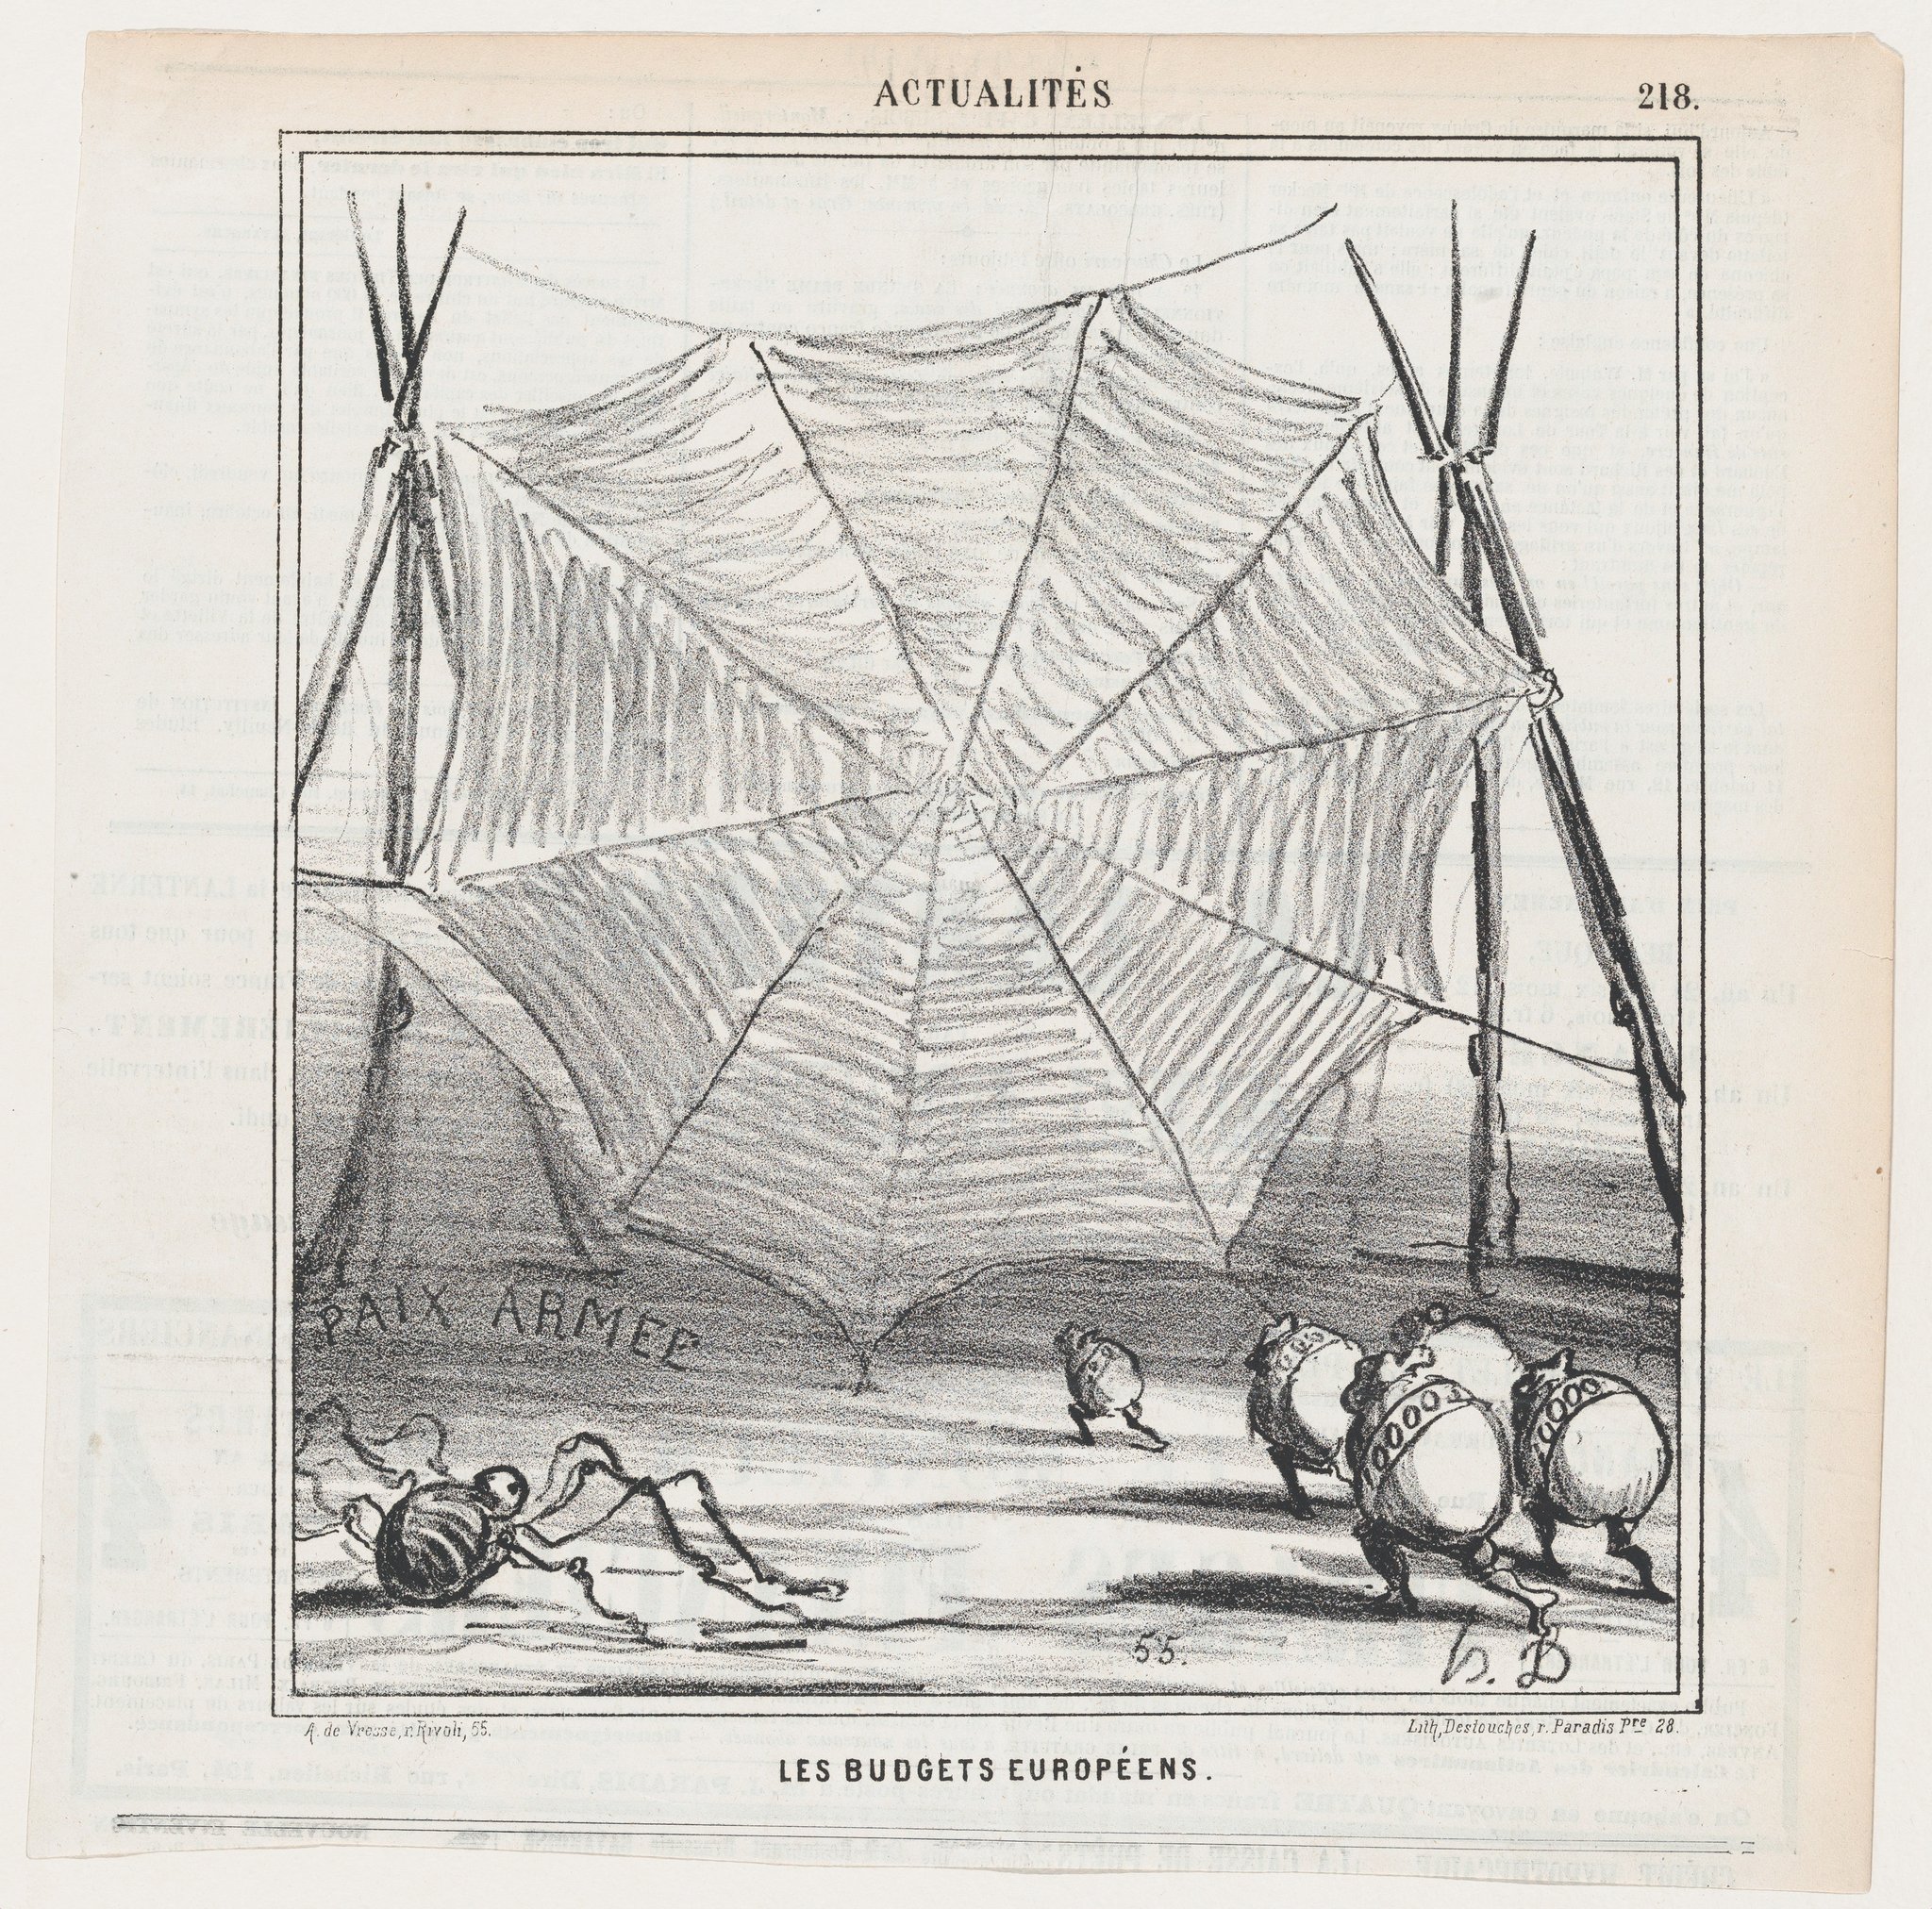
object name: print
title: European Budgets, from 'News of the day,' published in "Le Charivari"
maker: honoré daumier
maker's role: artist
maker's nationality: french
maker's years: 1808-1879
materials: paper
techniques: lithograph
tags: animals,satire